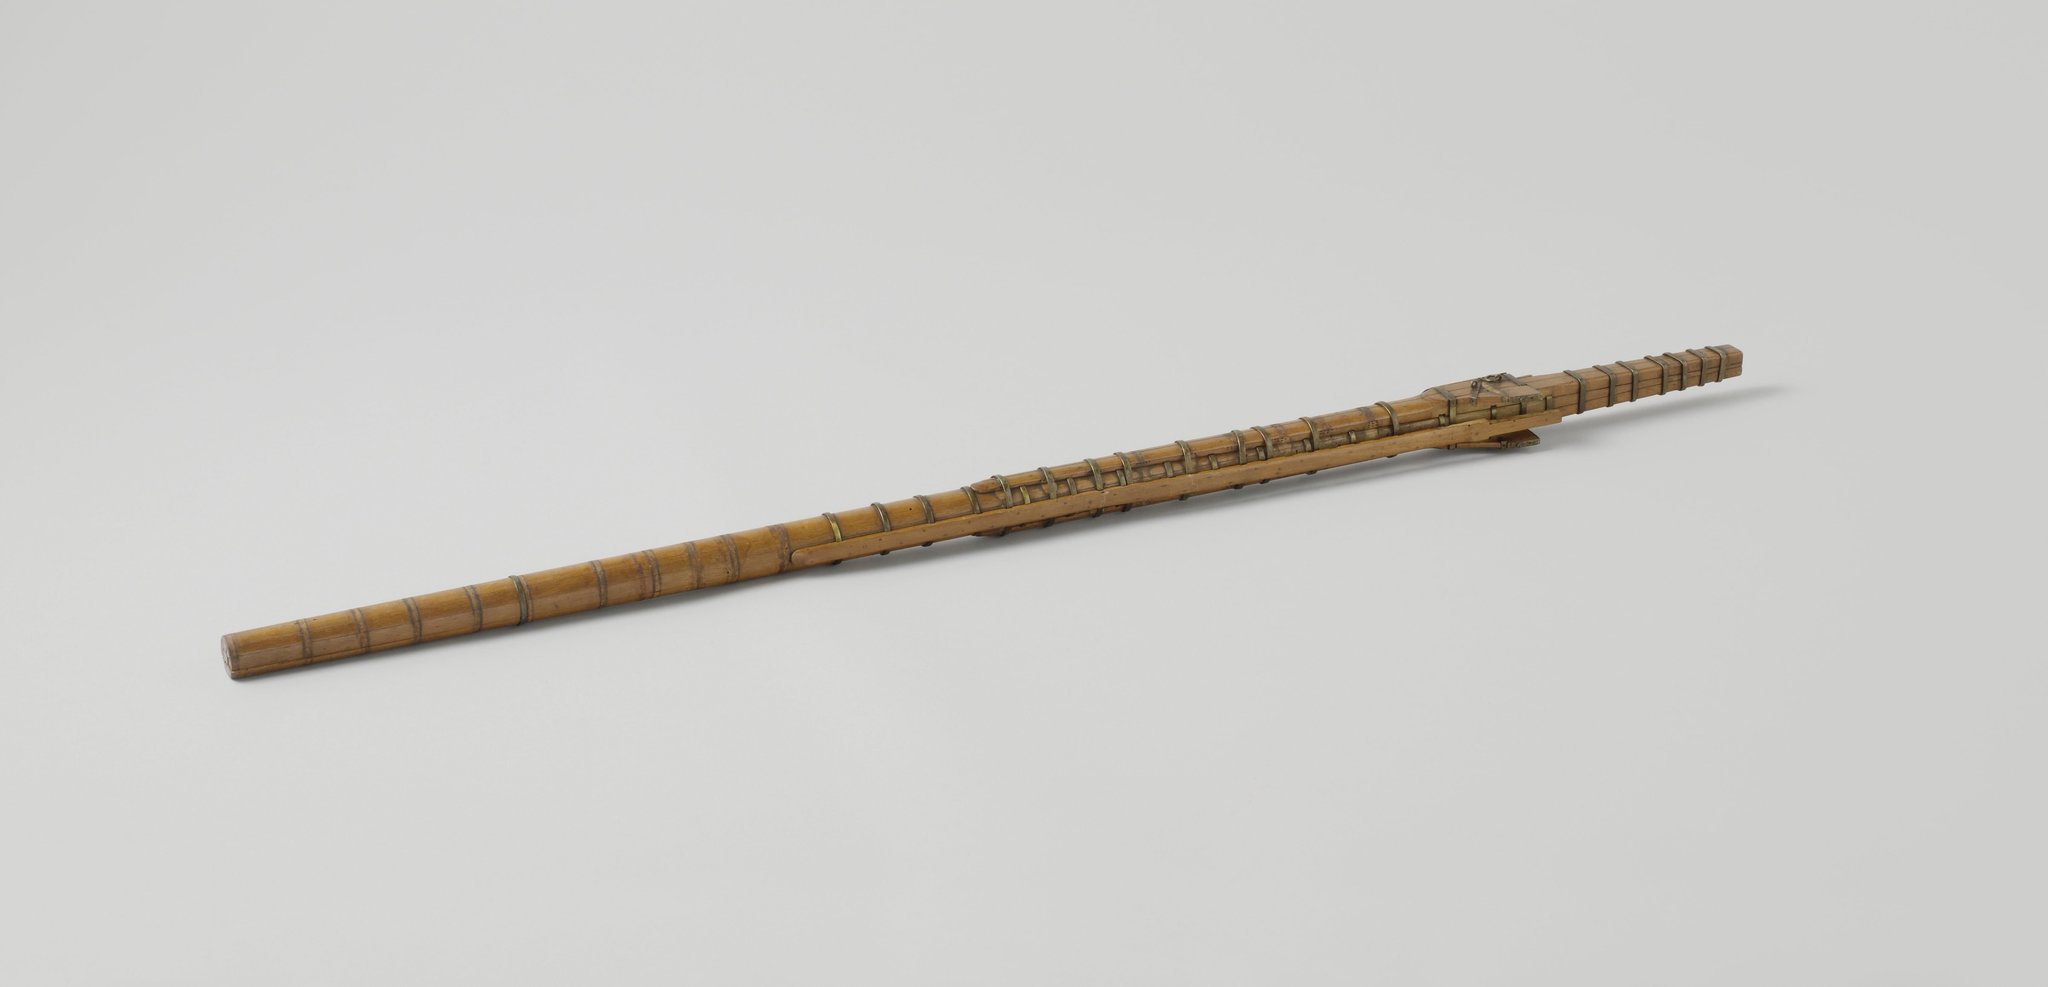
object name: demonstration model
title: Model of a Made Mast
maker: Anonymous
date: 1819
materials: brass, wood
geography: port mahon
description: Dit model stelt het ontwerp van J. Fennenias voor de grote mast van het linieschip van 74 stukken Willem de Eerste voor (Pieter van Zwijndregt Pzn., Rotterdam 1782-1785, hernoemd Brutus in 1795, hernoemd Braband in 1806, gesloopt in 1820); de eerste mast, voorgesteld door NG-MC-138-1, werd in 1819 afgekeurd en te Port Mahon vervangen door deze.